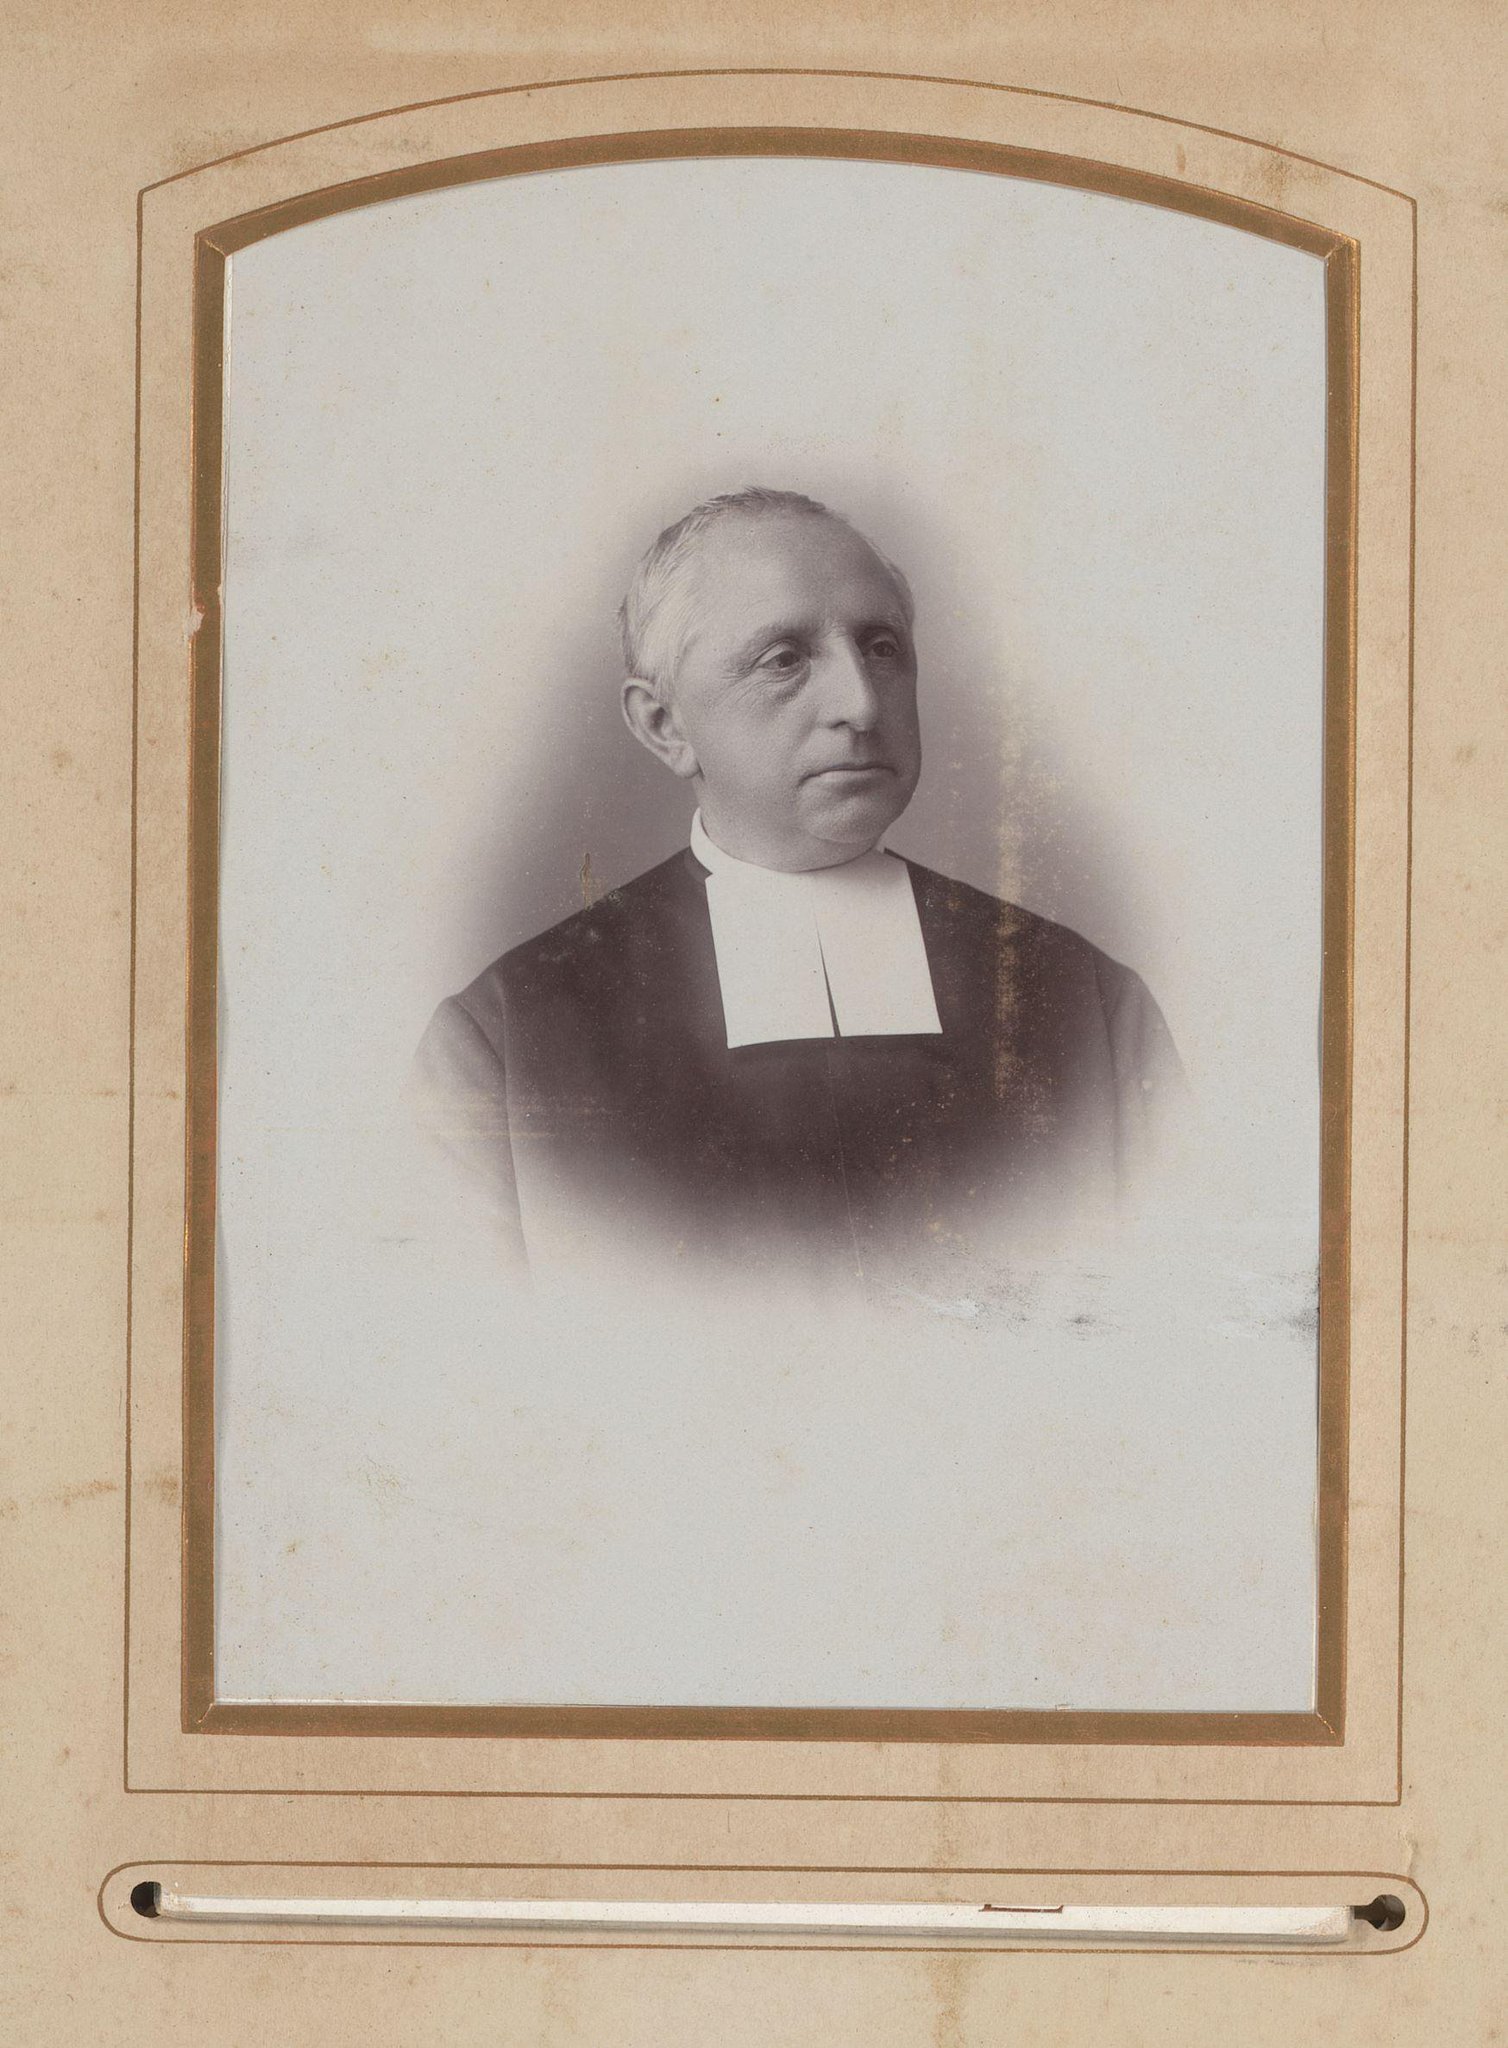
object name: album leaf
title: Portret van een geestelijke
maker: emile morren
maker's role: fotograaf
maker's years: 1865-1941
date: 1894-1914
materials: cardboard, photographic support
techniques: collodion silver print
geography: leuven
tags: historical persons, monk(s), friar(s)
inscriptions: inscription: ‘Emile Morren/ Photographe de/ S.A.S. Mgr le Duc d'Arenberg/ 18/ Rue de Namur/ (en face la rue de la Monnaie)/ LOouvain/ Les Clichés sont conservés.’